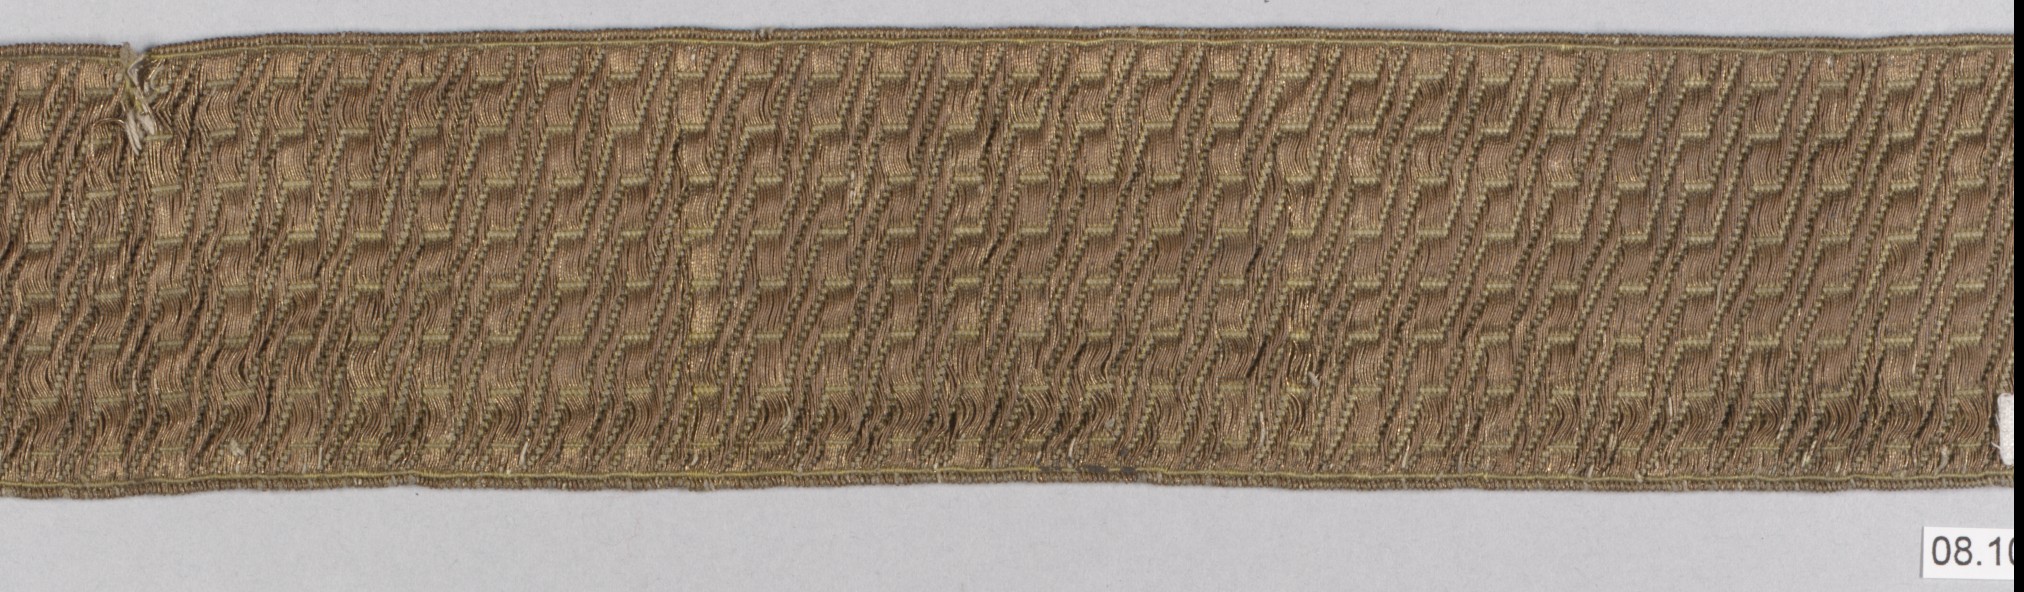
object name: galloon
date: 1601-1800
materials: metal thread